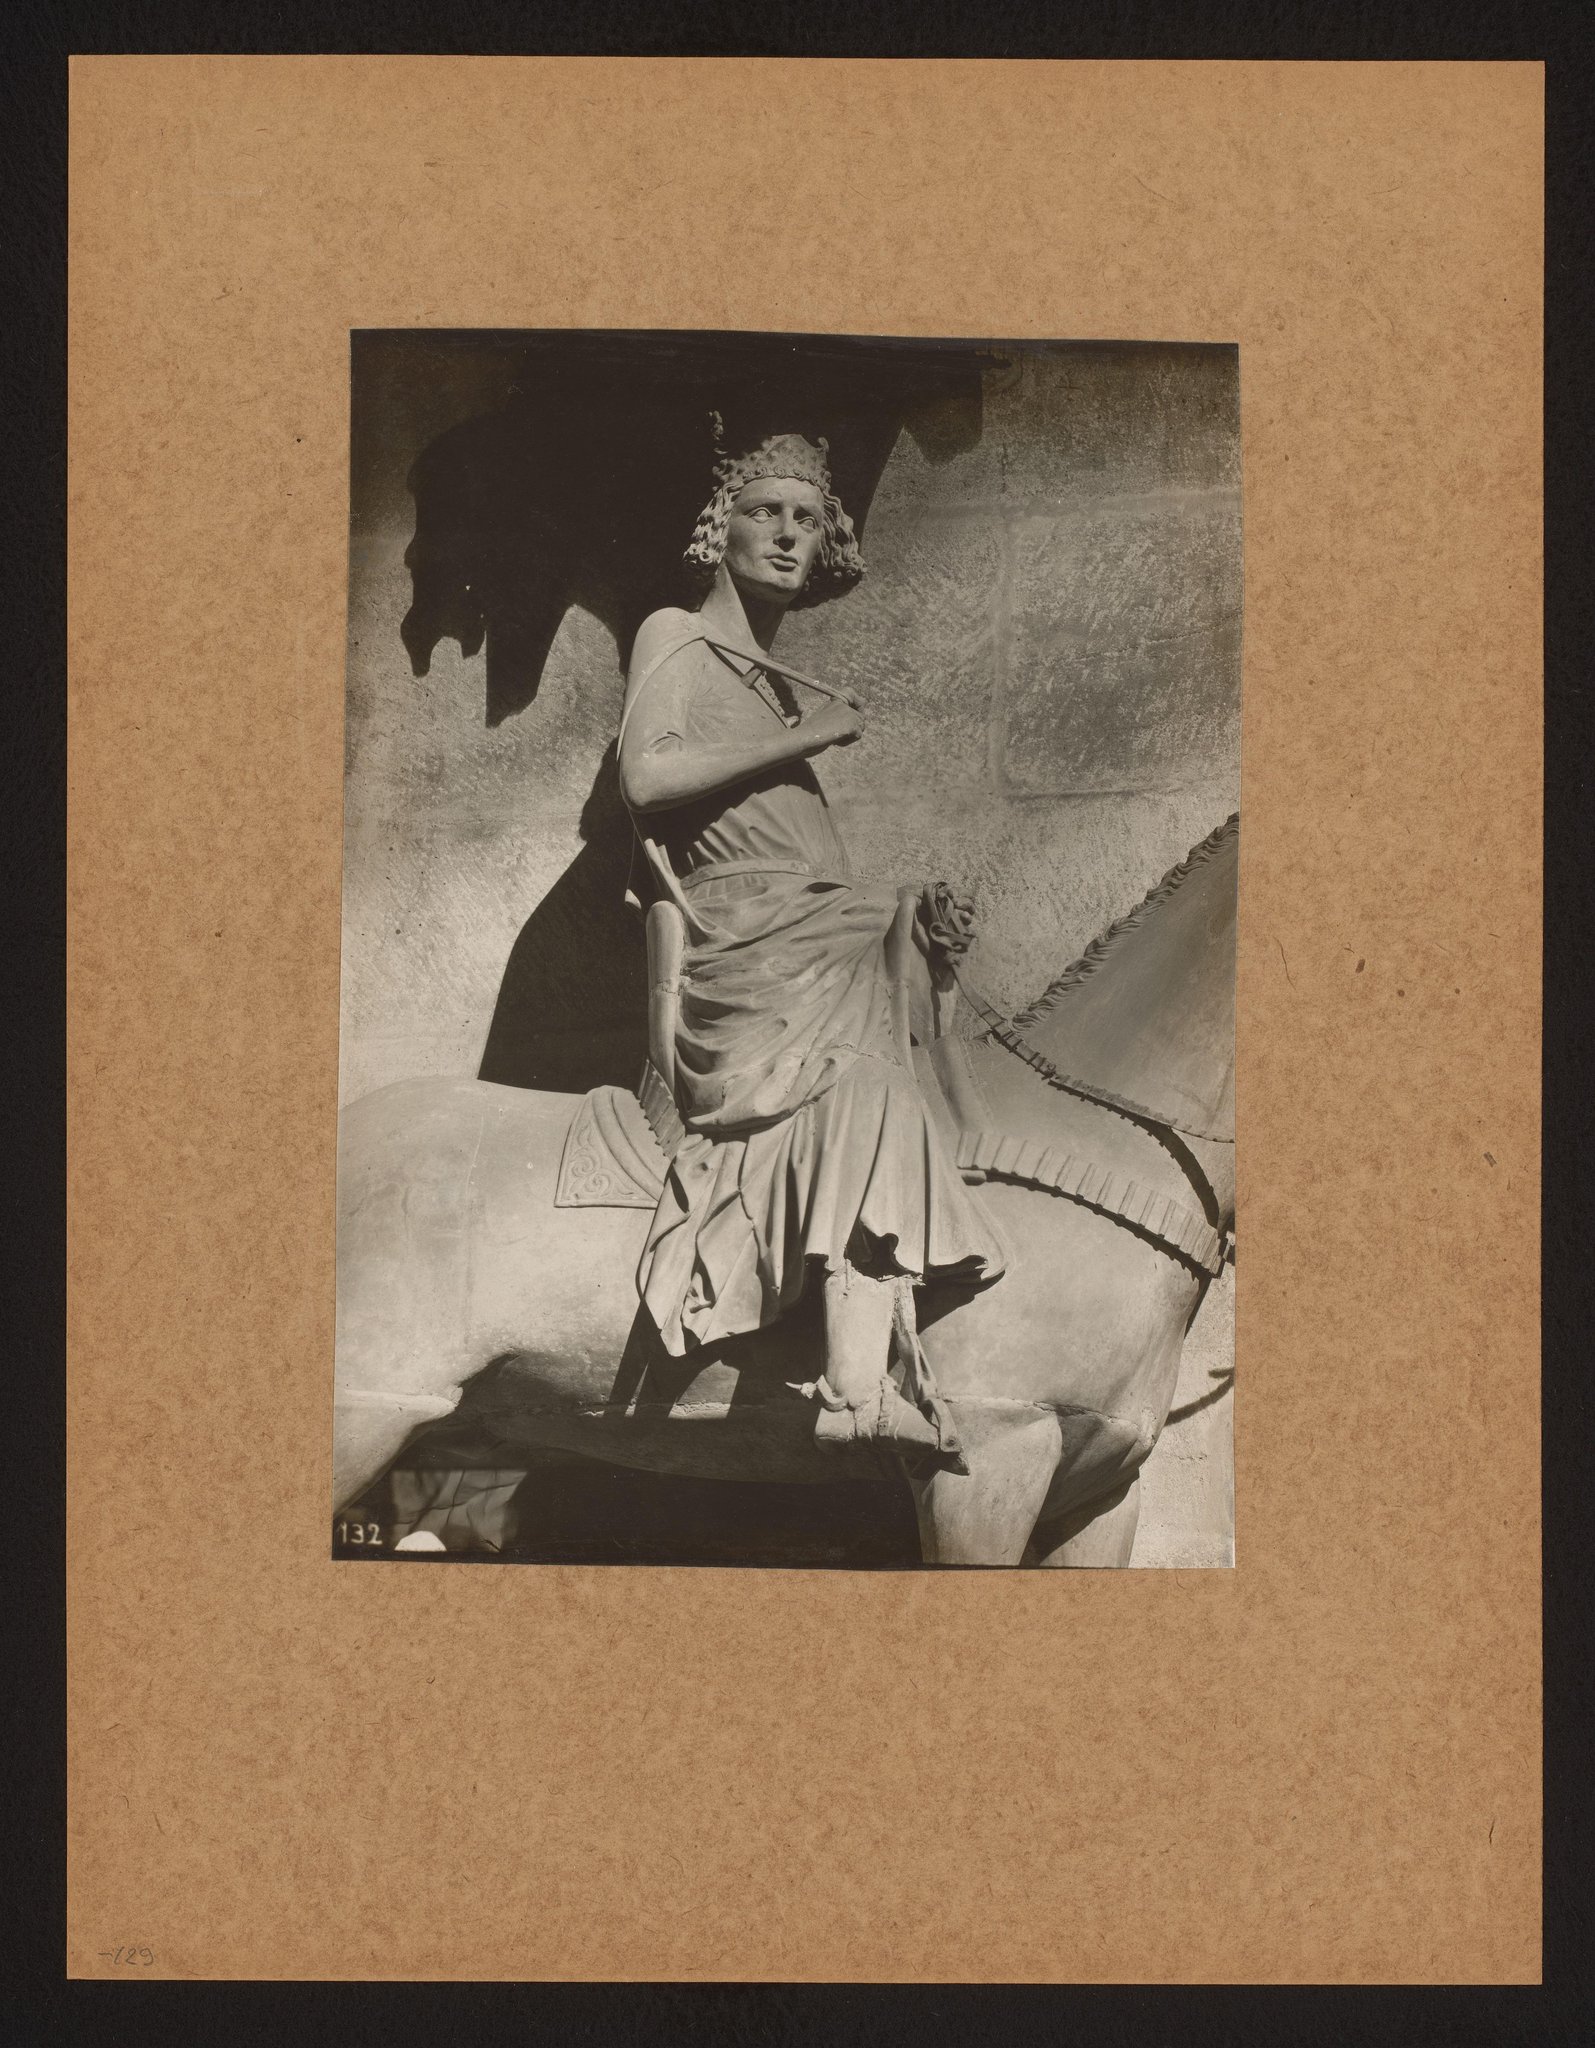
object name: photograph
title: Der Reiter, ohne Pferd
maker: Anonymous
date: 1900-1920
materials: paper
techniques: gelatin silver print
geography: bamberg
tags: riding a horse, ass, or mule; rider, horseman, interior of church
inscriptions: number: ‘132’